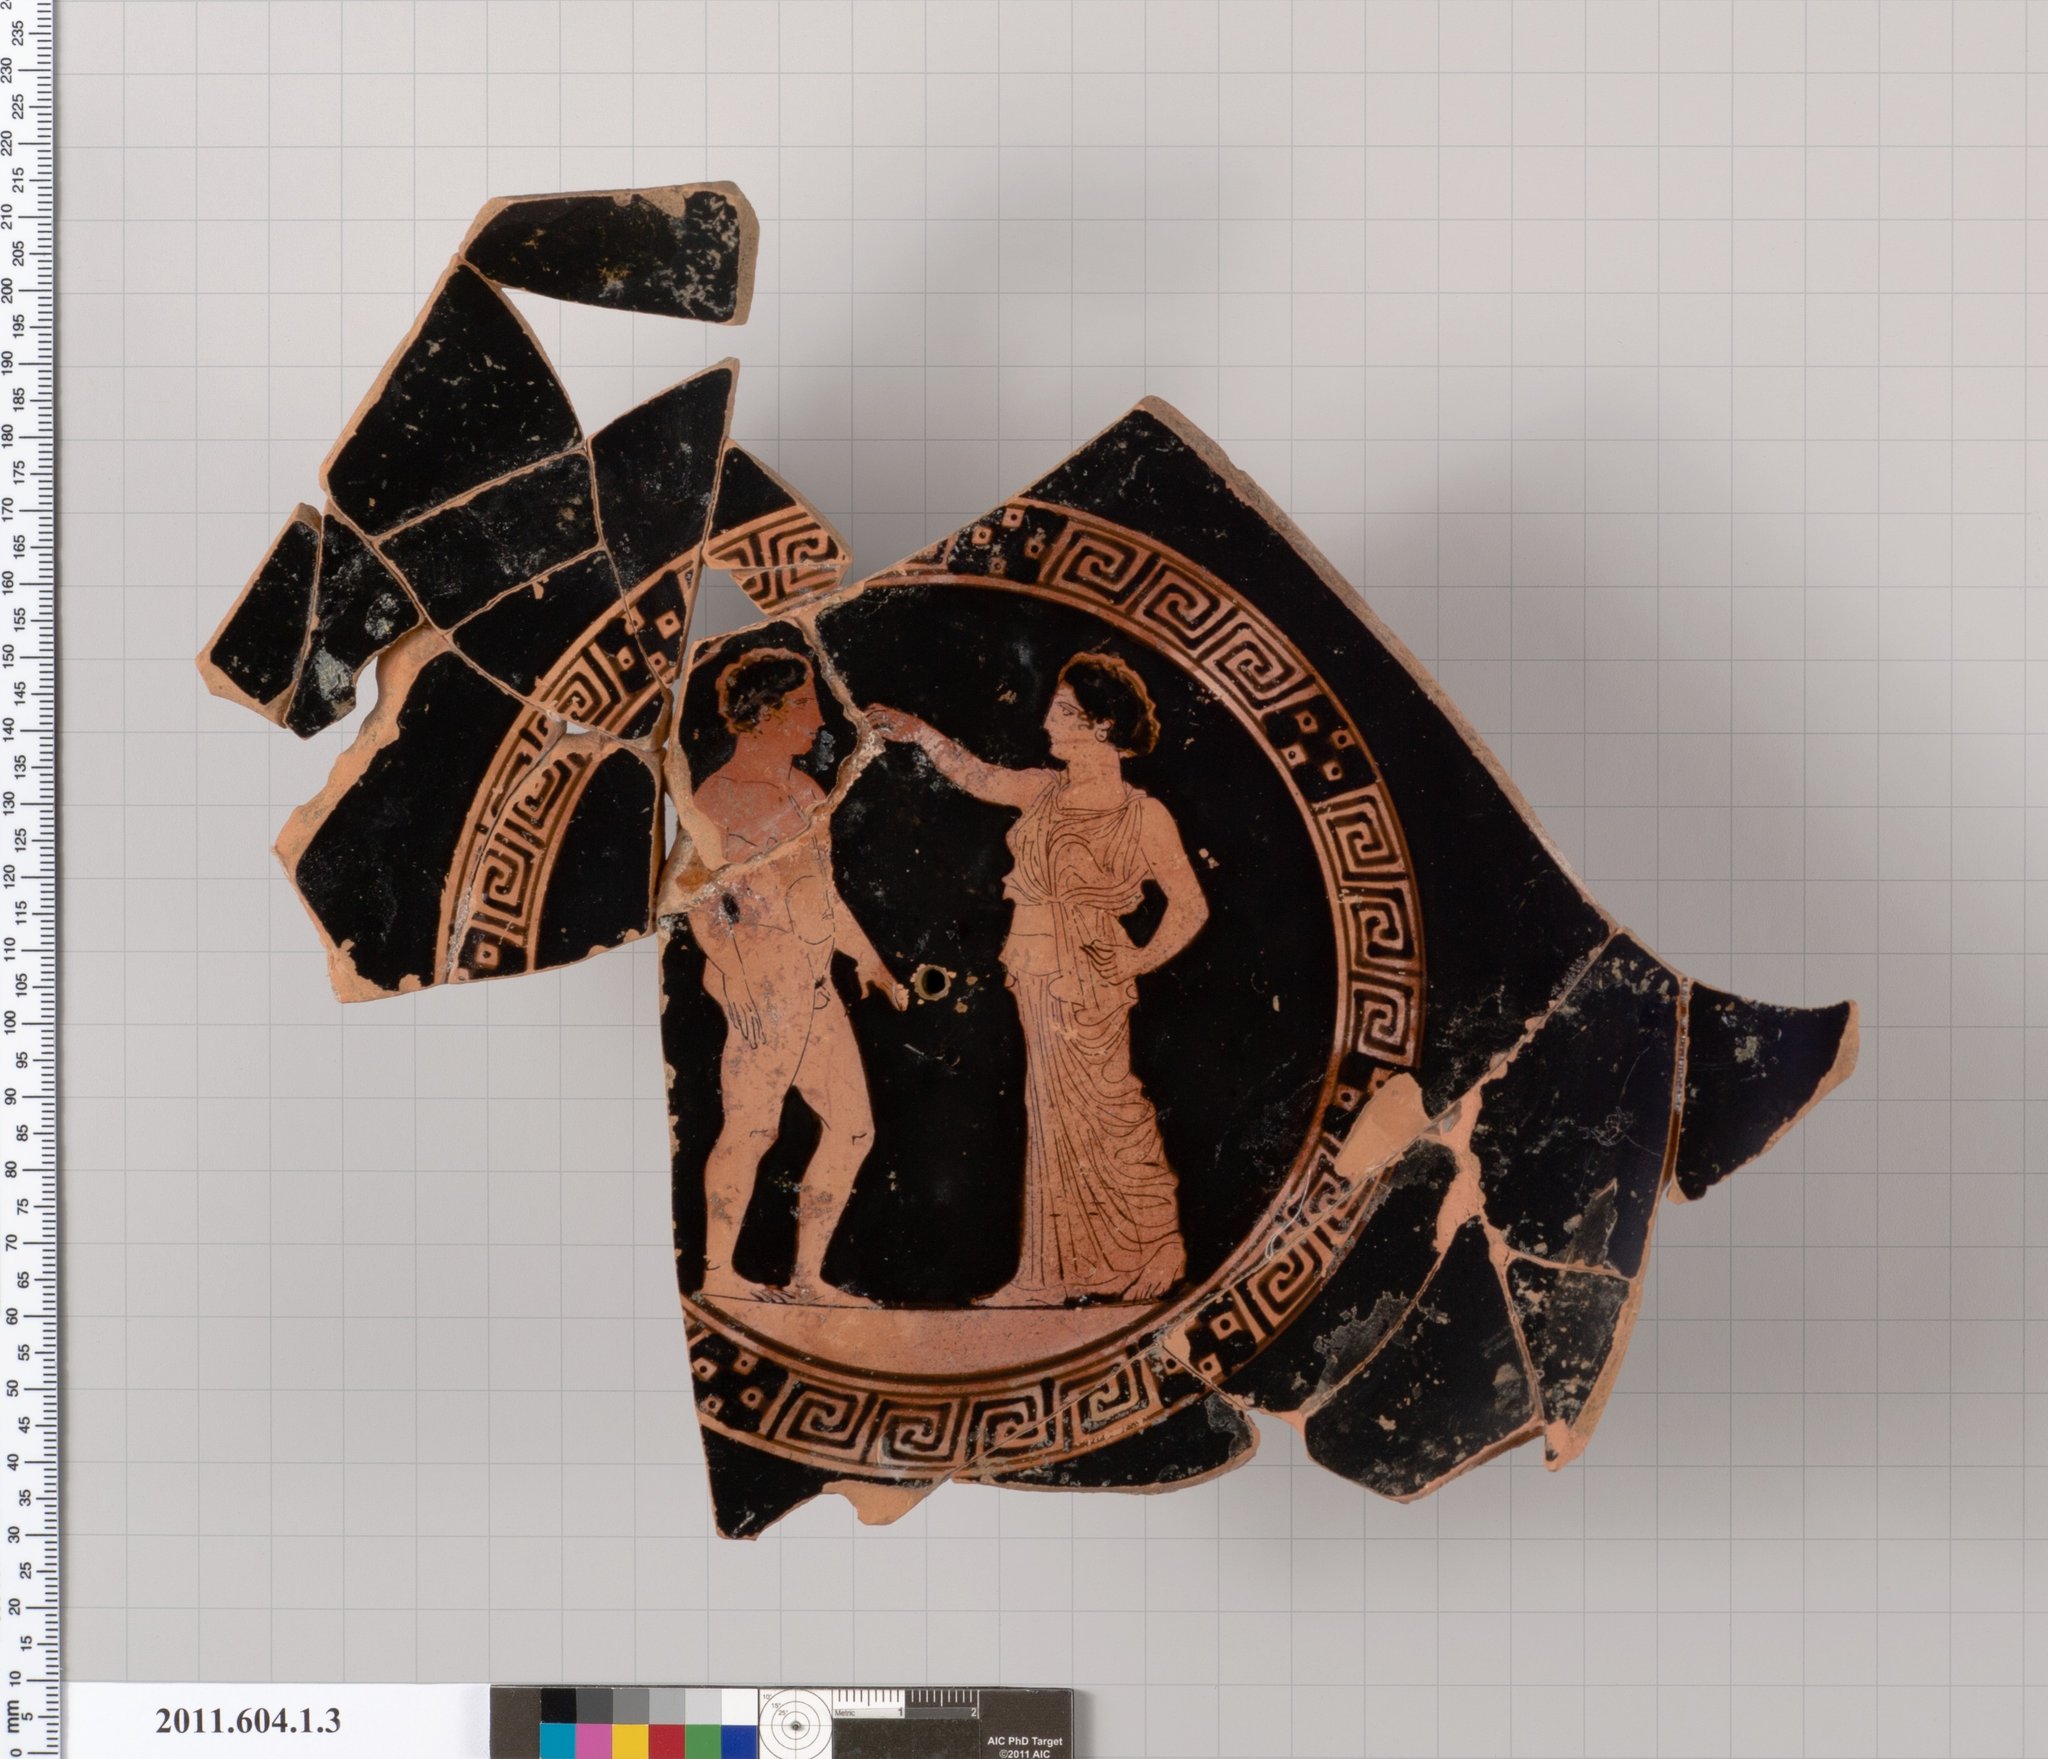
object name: kylix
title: Terracotta kylix (drinking cup)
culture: greek, attic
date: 467-435 BCE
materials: terracotta